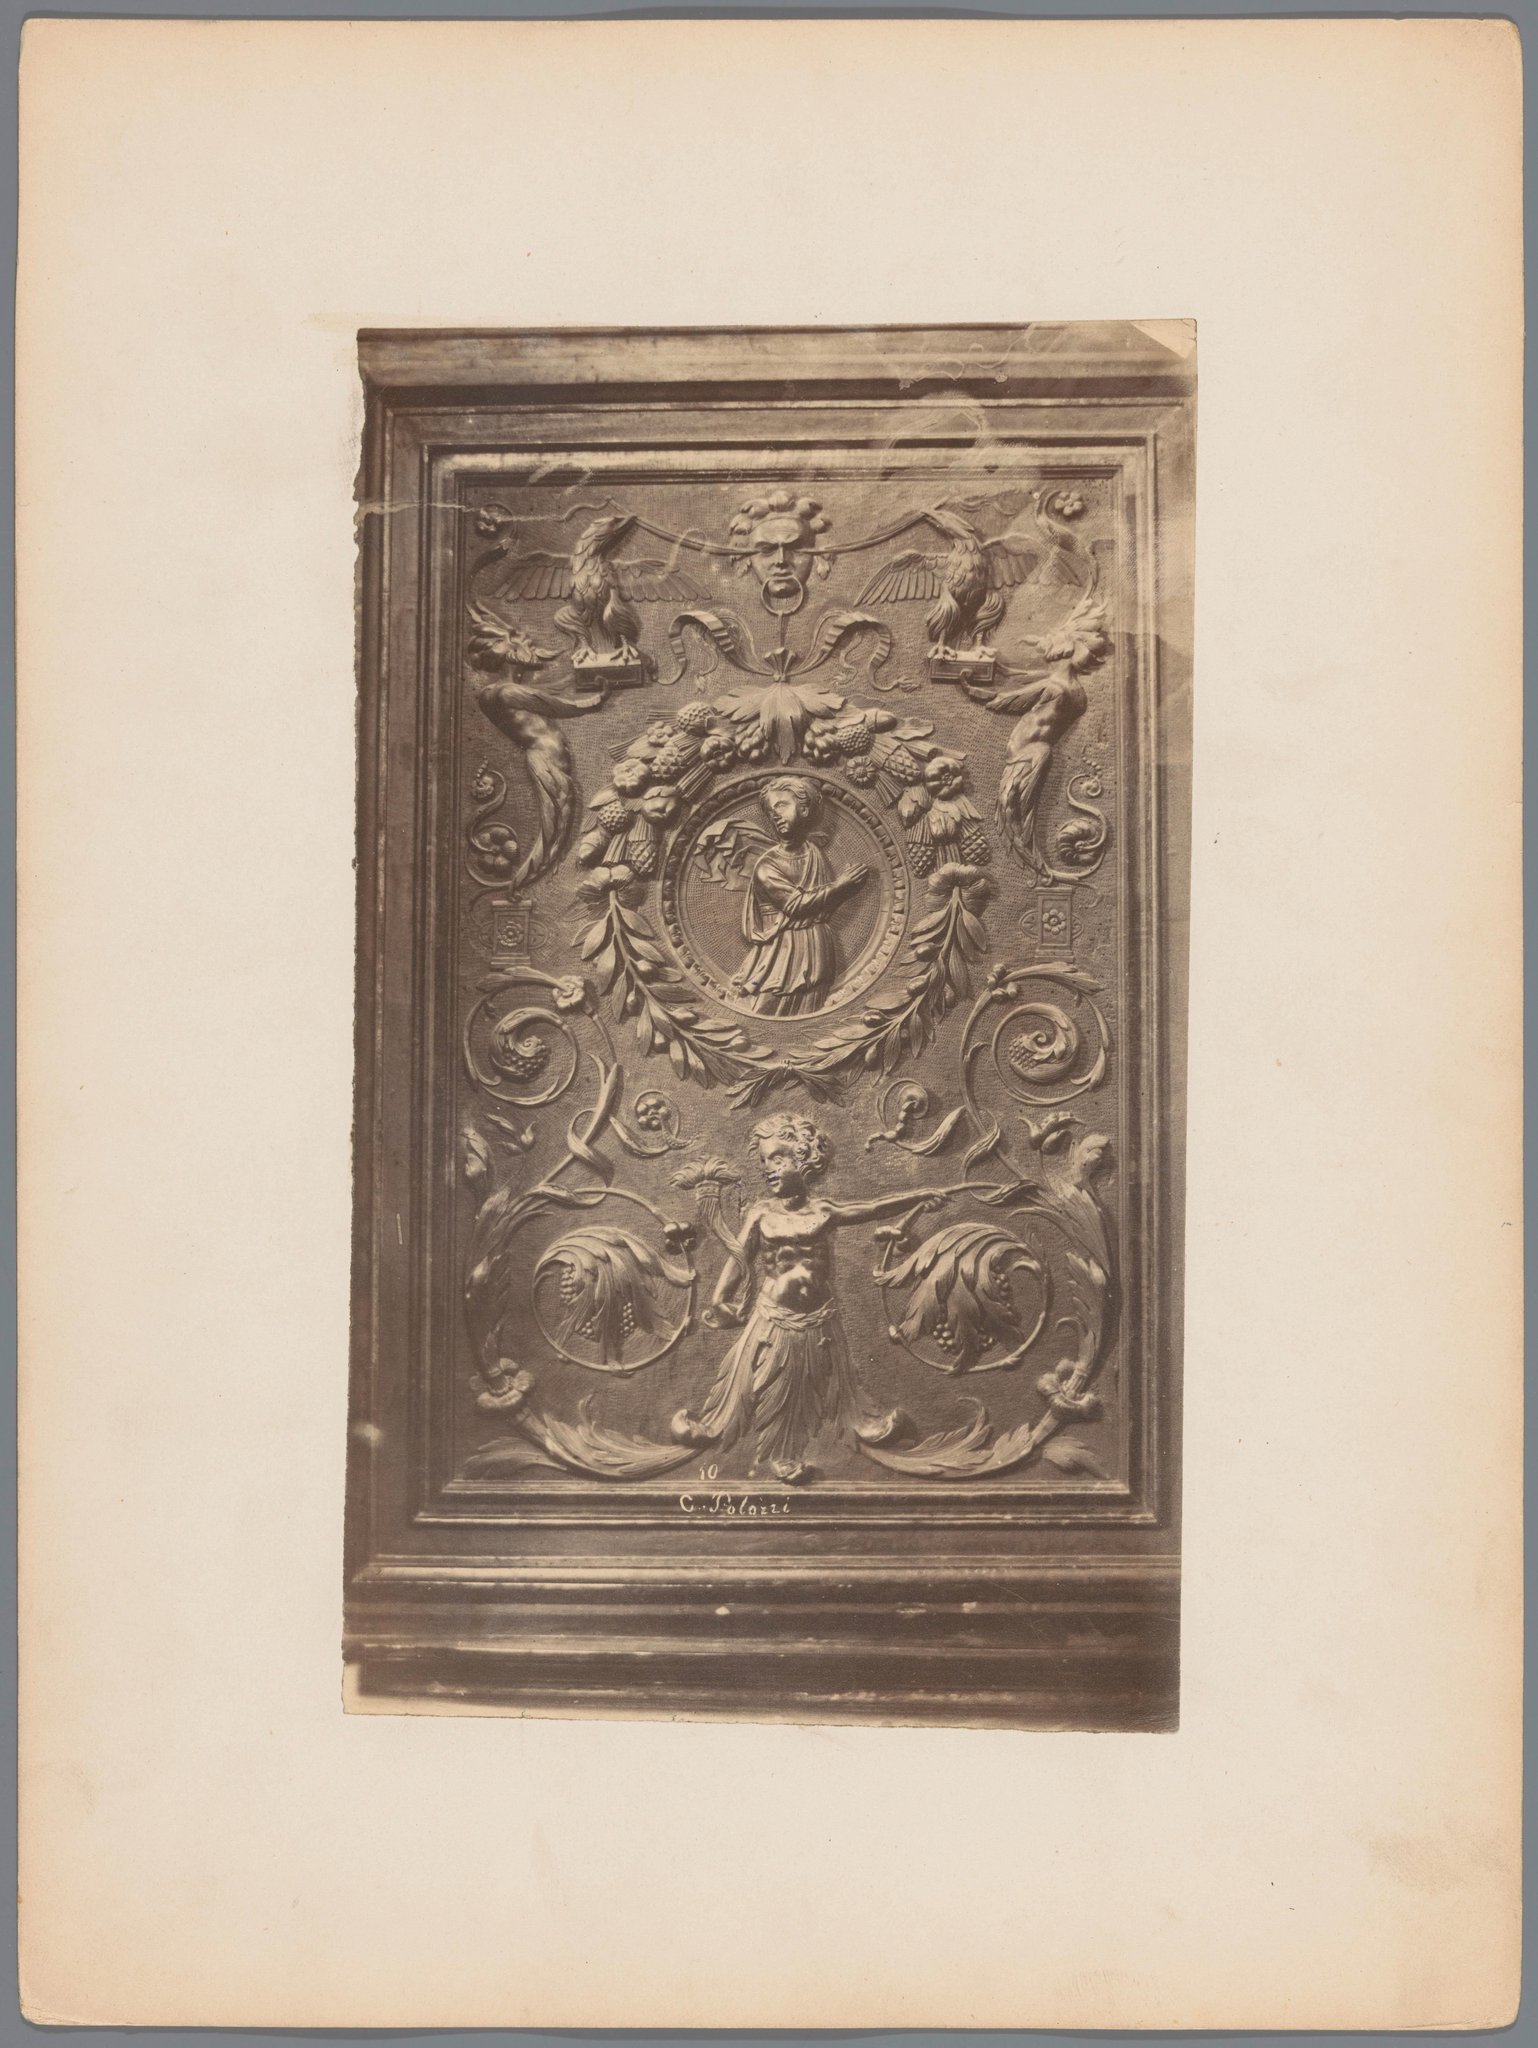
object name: photograph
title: Paneel met een omkranste man, een kindfiguur, vogels en arabesken in reliëf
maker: c. polozzi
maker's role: fotograaf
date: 1875-1900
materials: cardboard, photographic support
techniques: albumen print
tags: ornamental birds, fruits and vegetables ~ ornament, ornament ~ arabesque, garland, wreath, decorating 'en relief', appliquéing, sculpture (+ relief ~ sculpture)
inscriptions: collector's mark: Lugt 3937, number: ‘10’